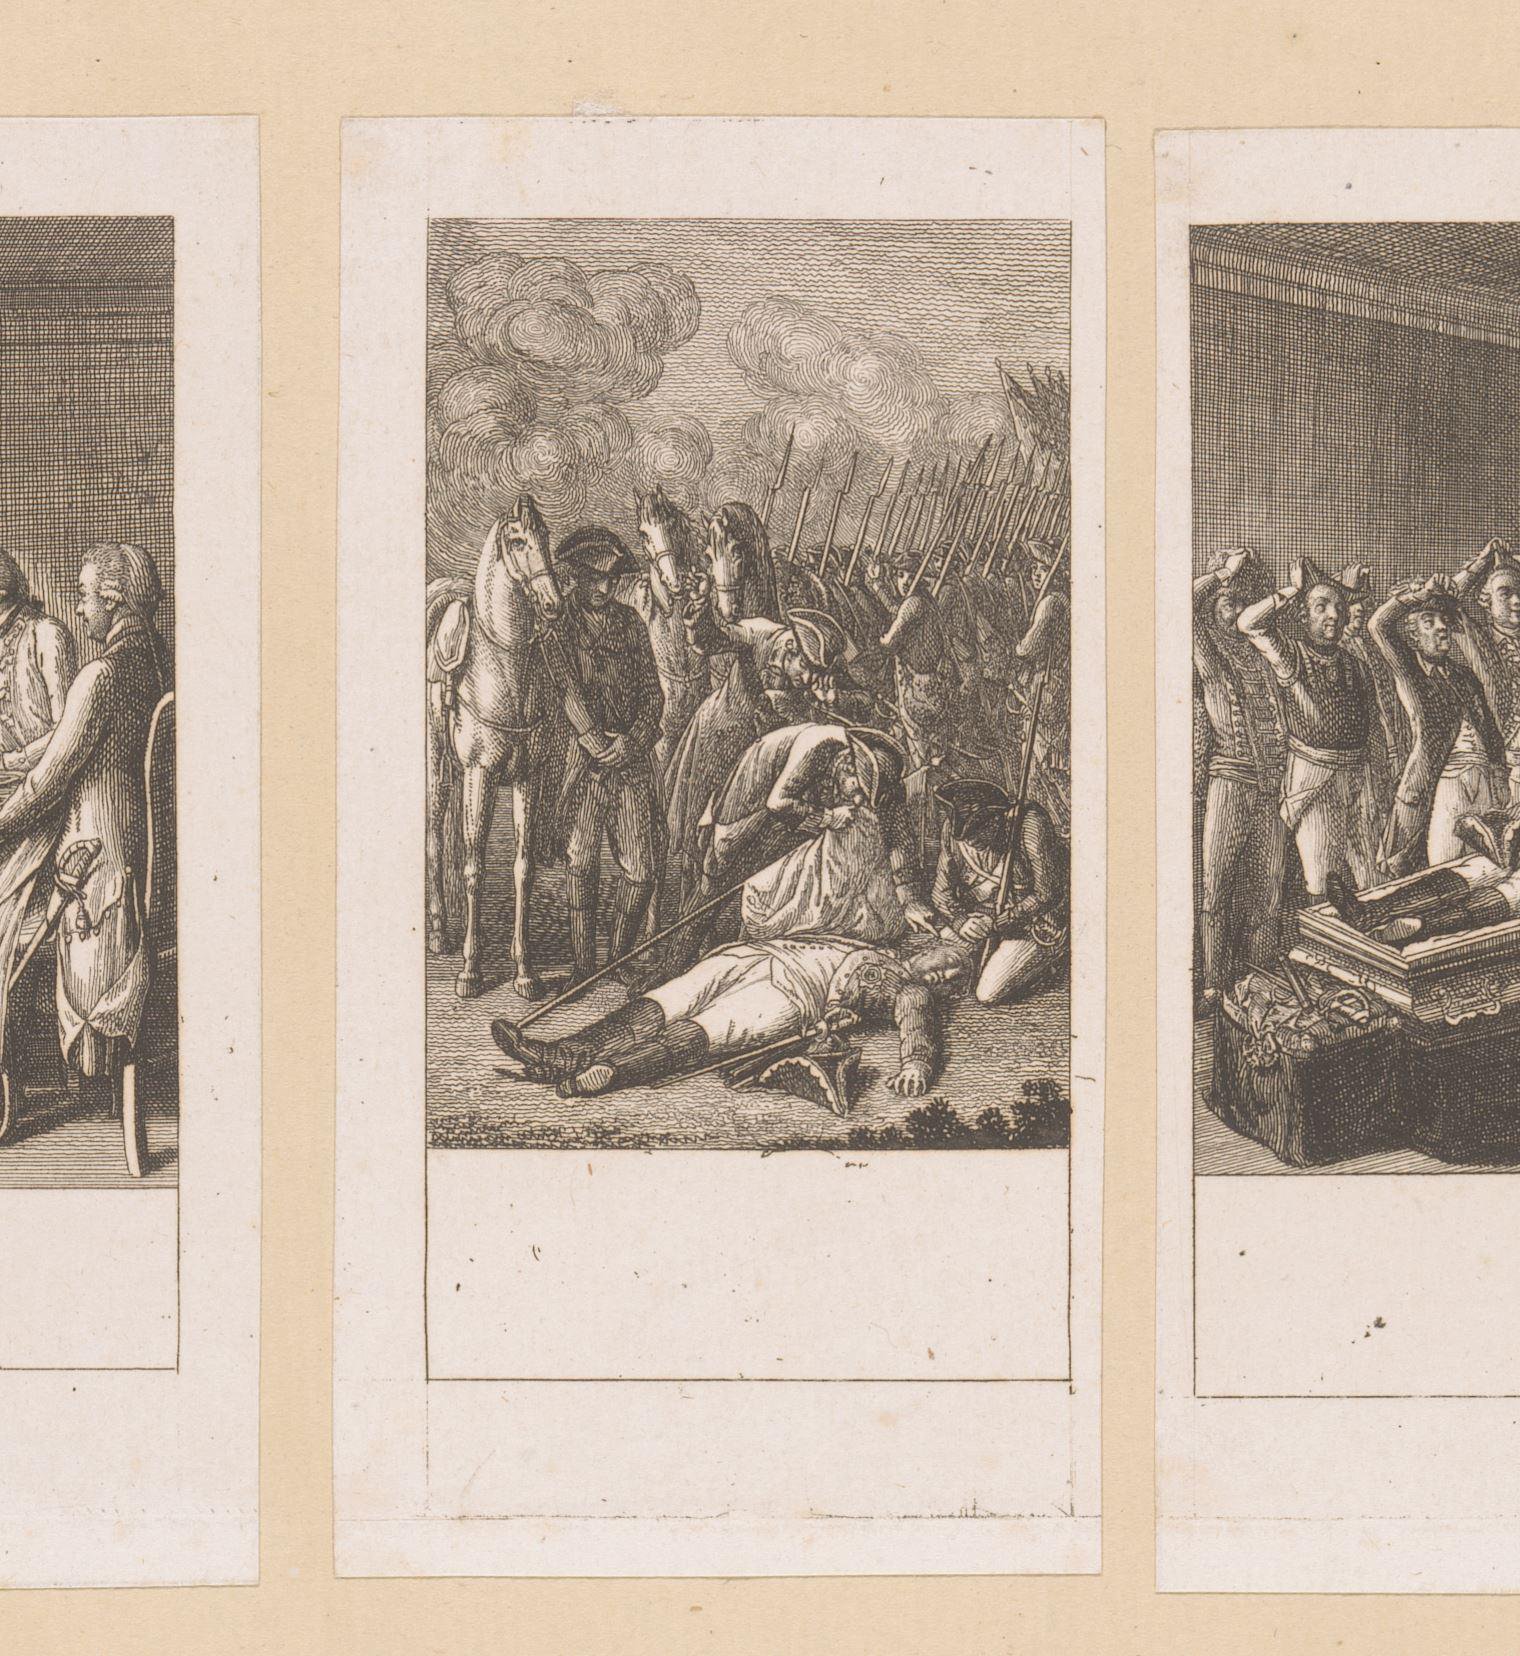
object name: print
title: Soldaten betreuren gesneuvelde soldaat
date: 1750-1849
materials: paper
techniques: etching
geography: germany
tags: mourning customs, the soldier; the soldier's life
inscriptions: collector's mark: Lugt 2228